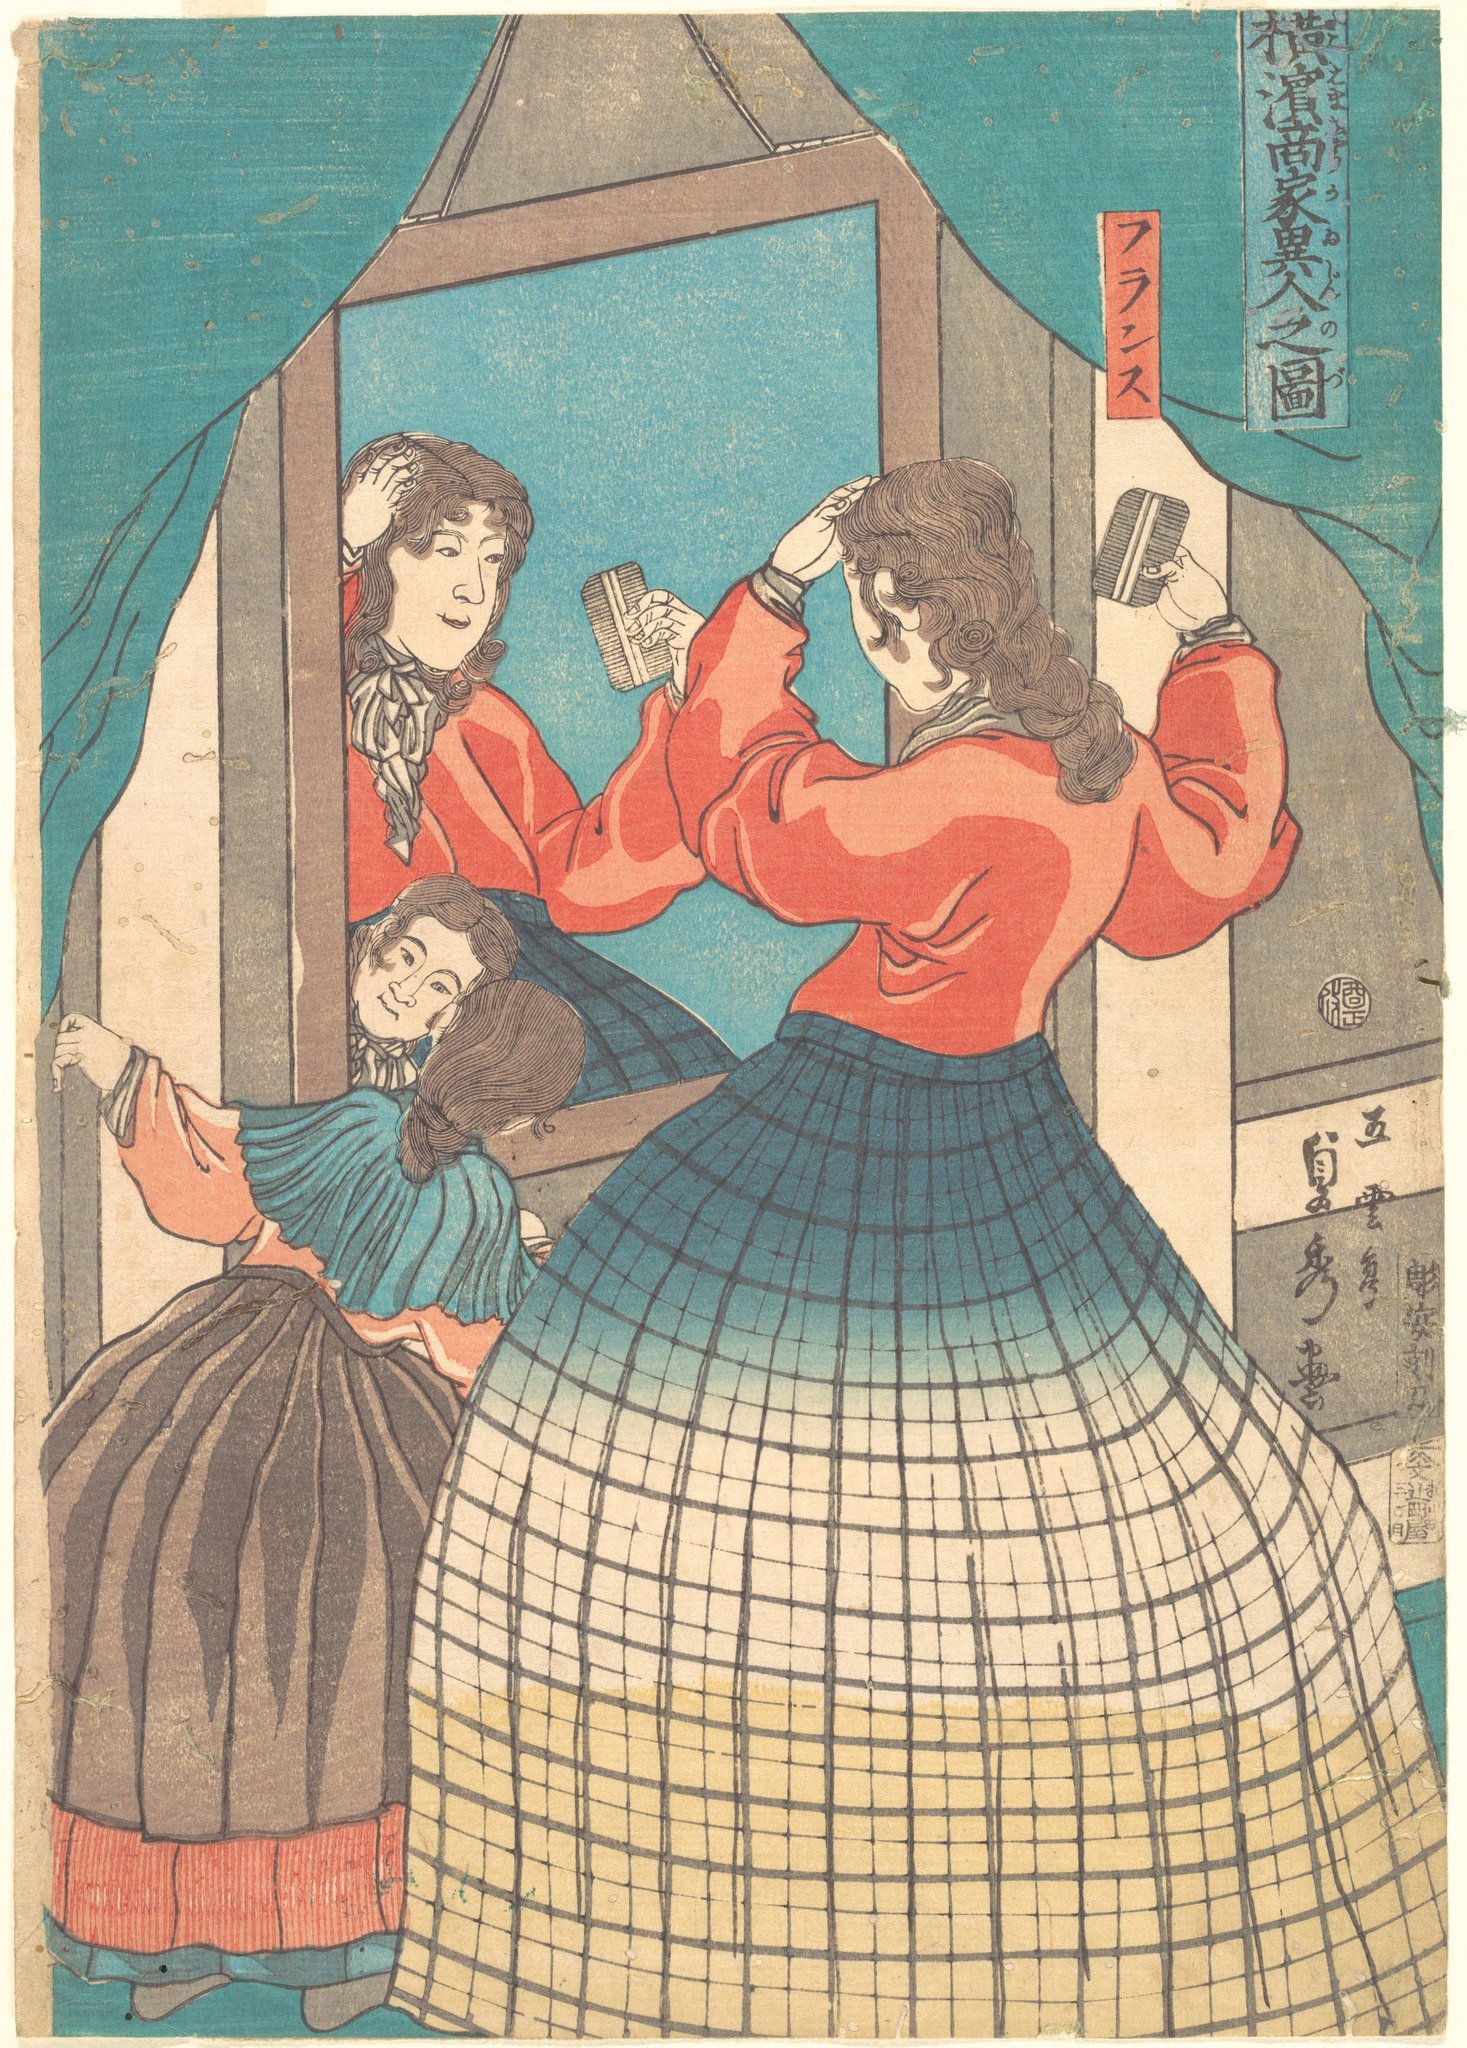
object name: print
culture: japanese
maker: utagawa (gountei) sadahide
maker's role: artist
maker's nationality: japanese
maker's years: 1807-1873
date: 1861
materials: ink, paper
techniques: woodblock print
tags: girls,women,mirrors